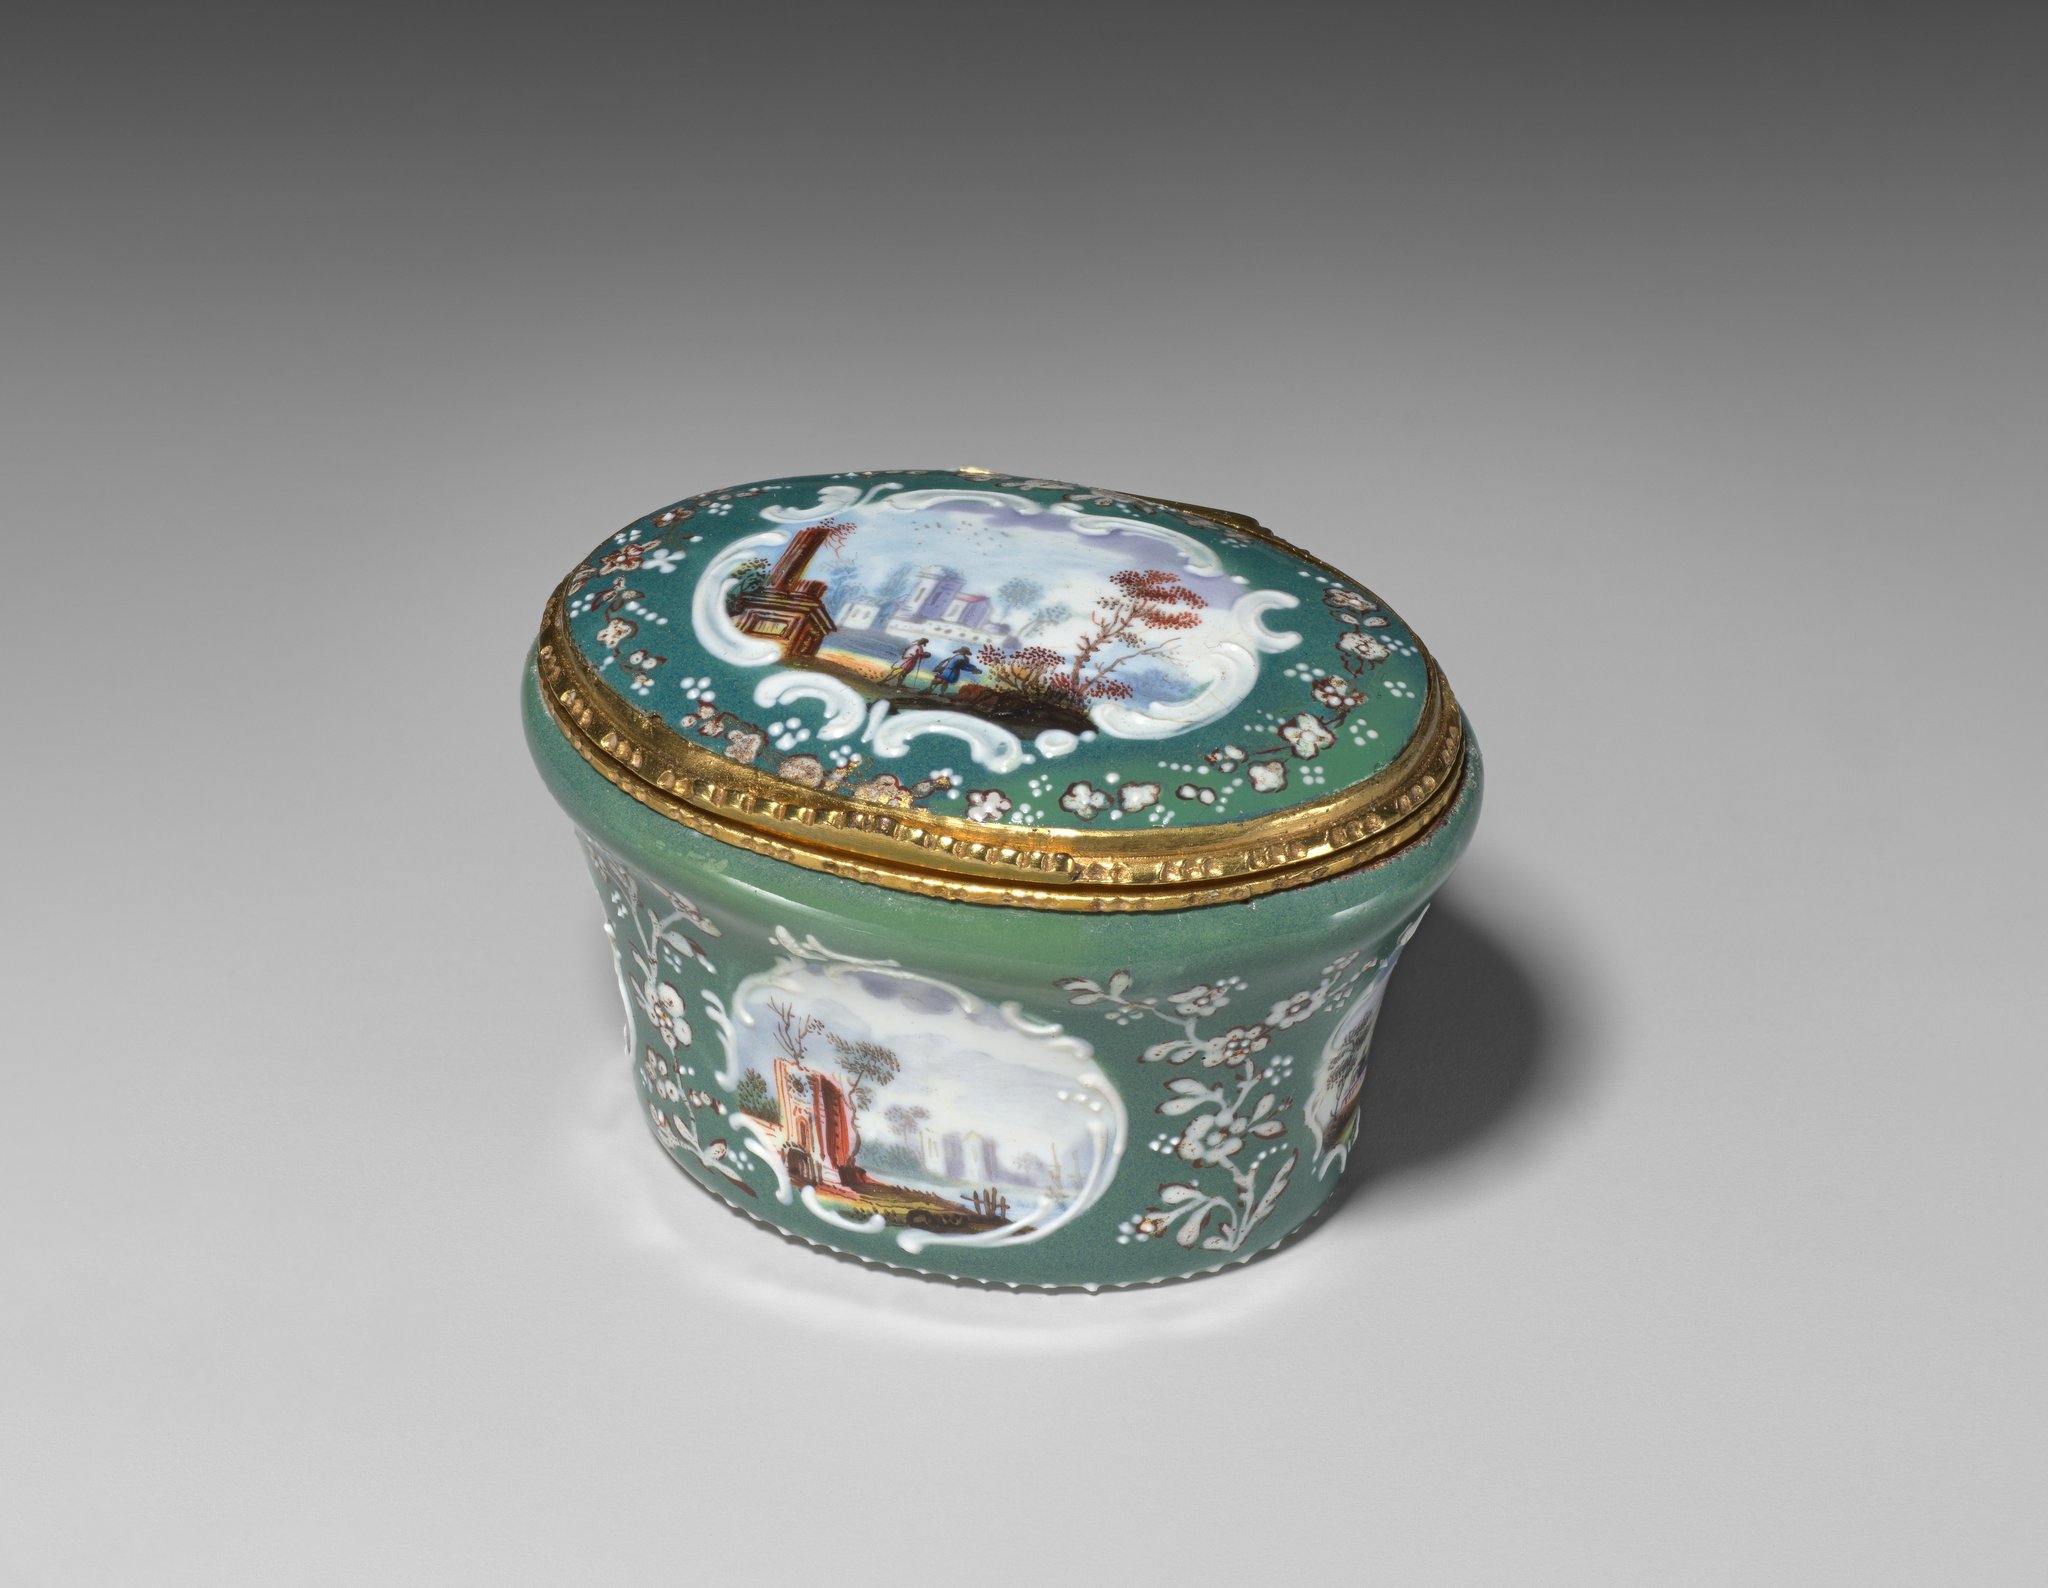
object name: bonbonnière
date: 1765-1770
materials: copper, enamel